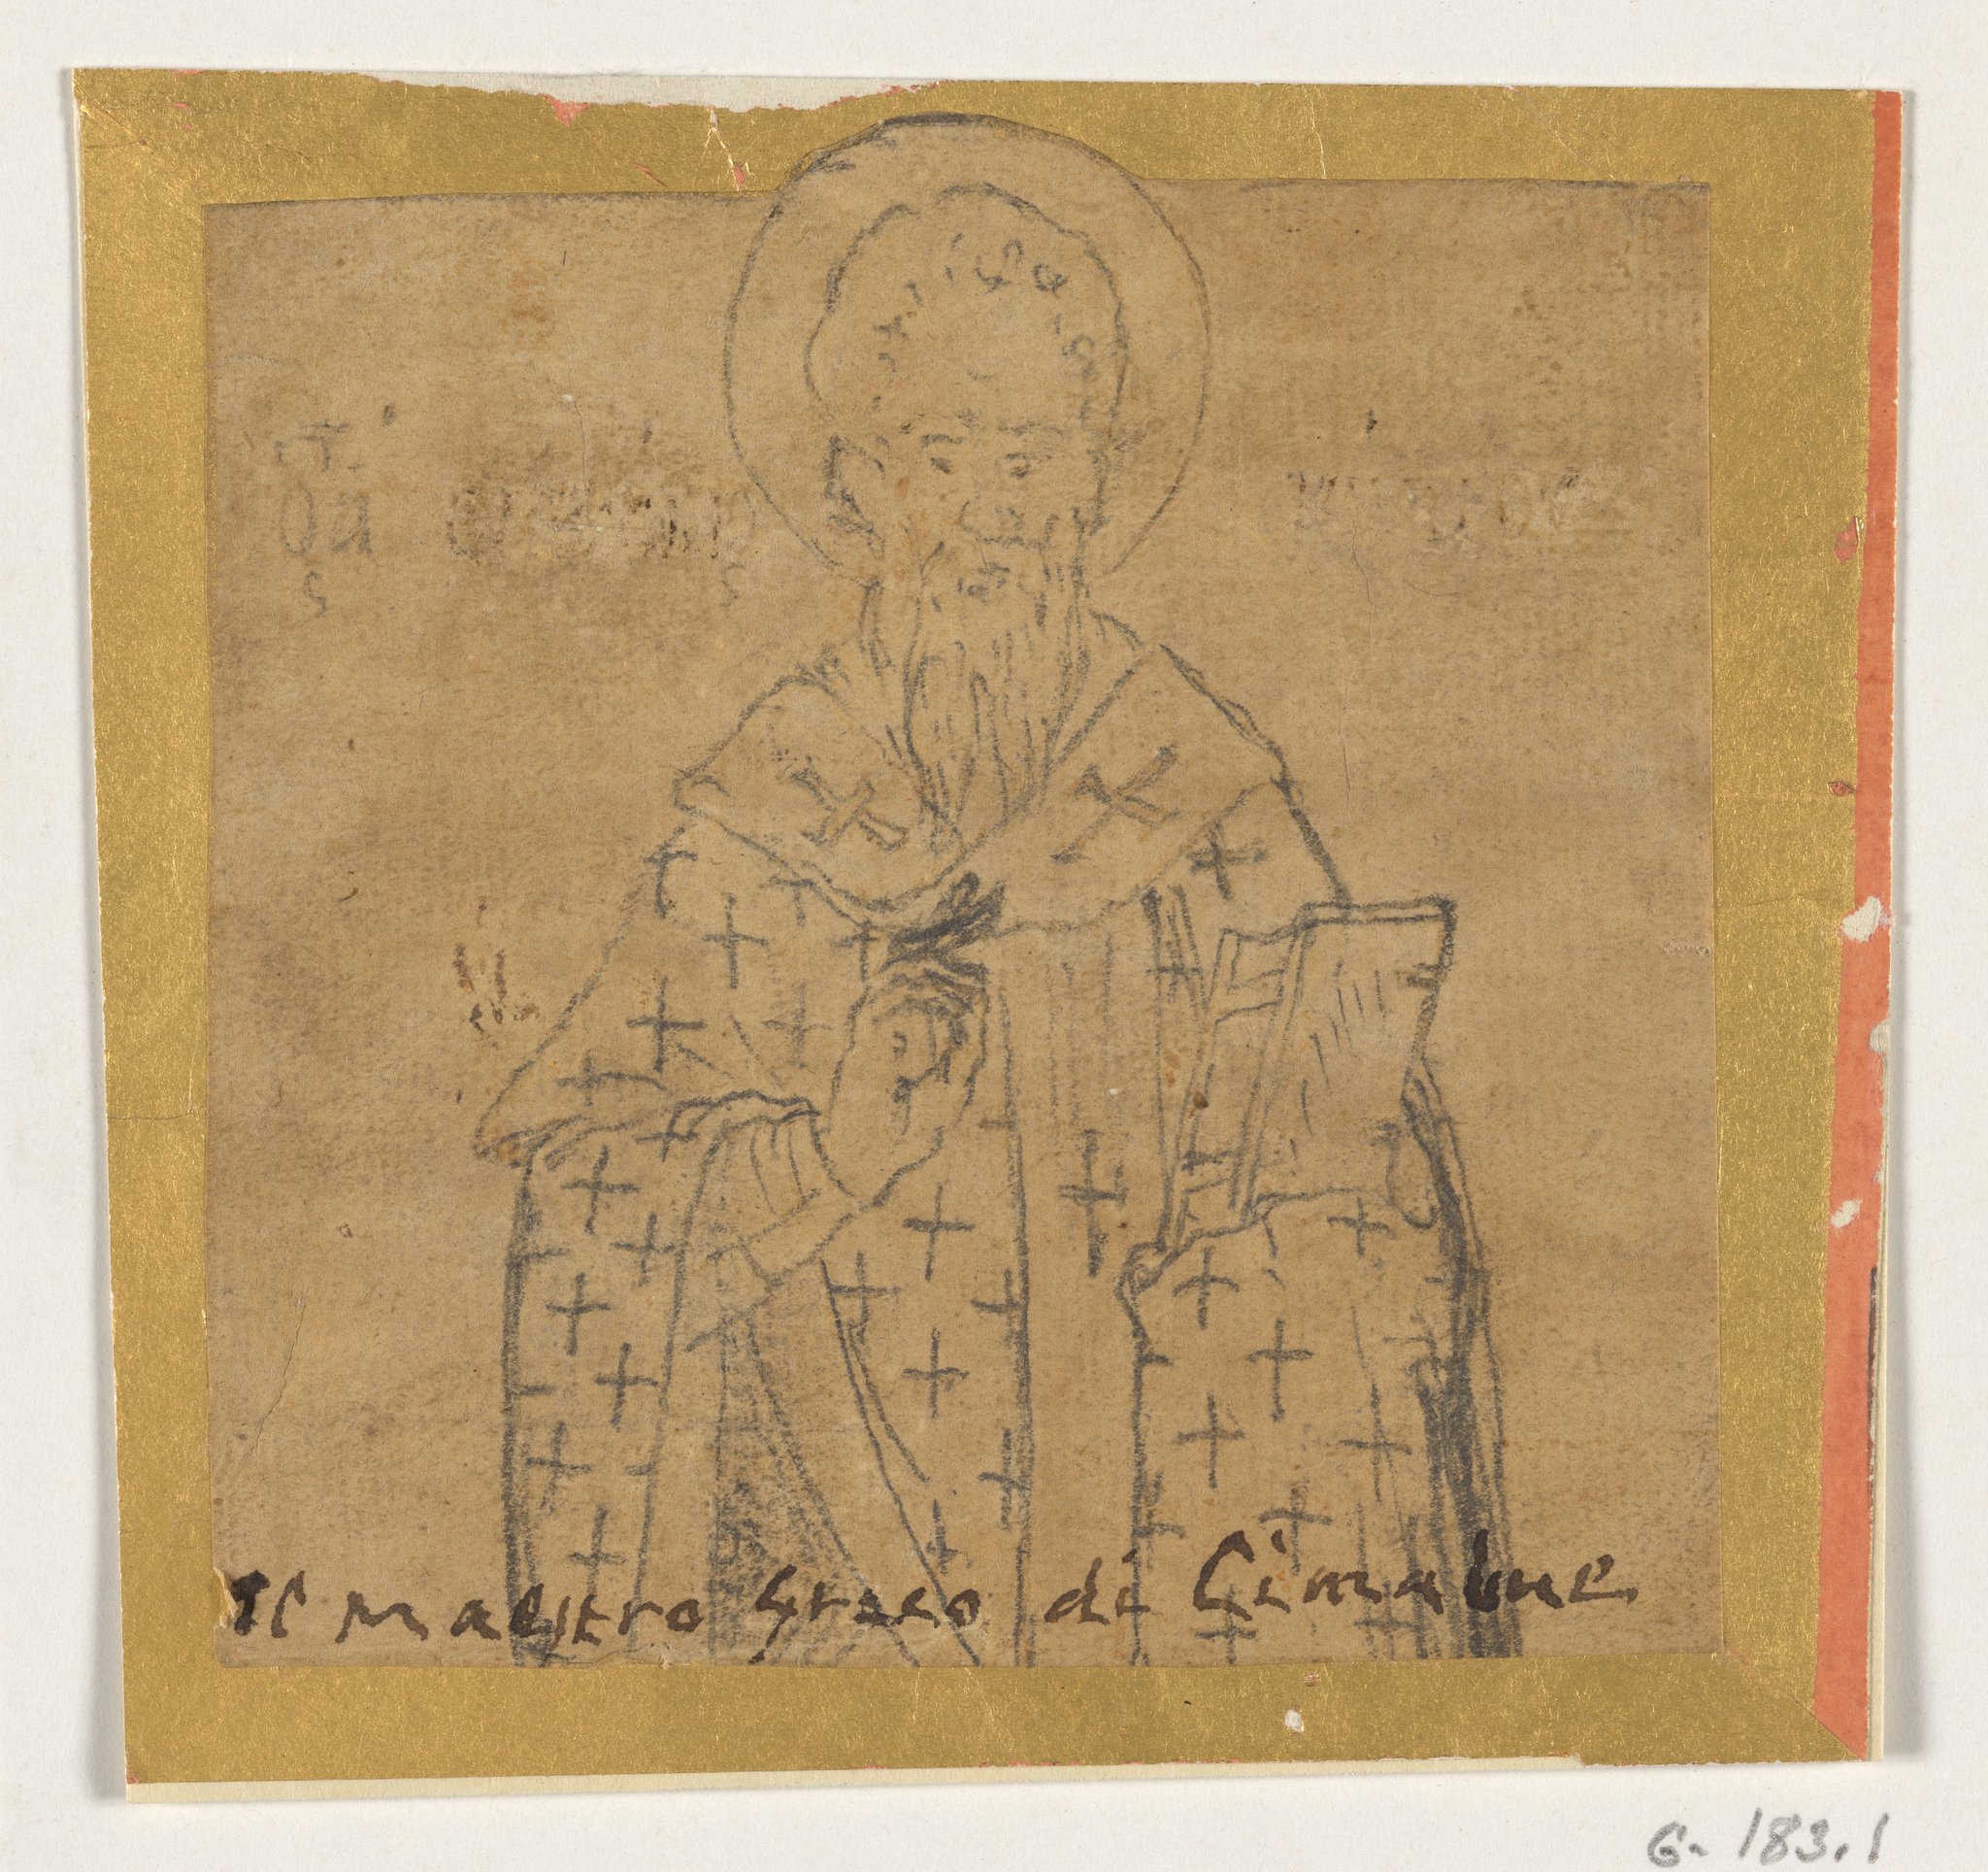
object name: drawing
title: Copy of a Russian Icon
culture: italian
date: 1867-1900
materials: graphite, paper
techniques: cutting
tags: men